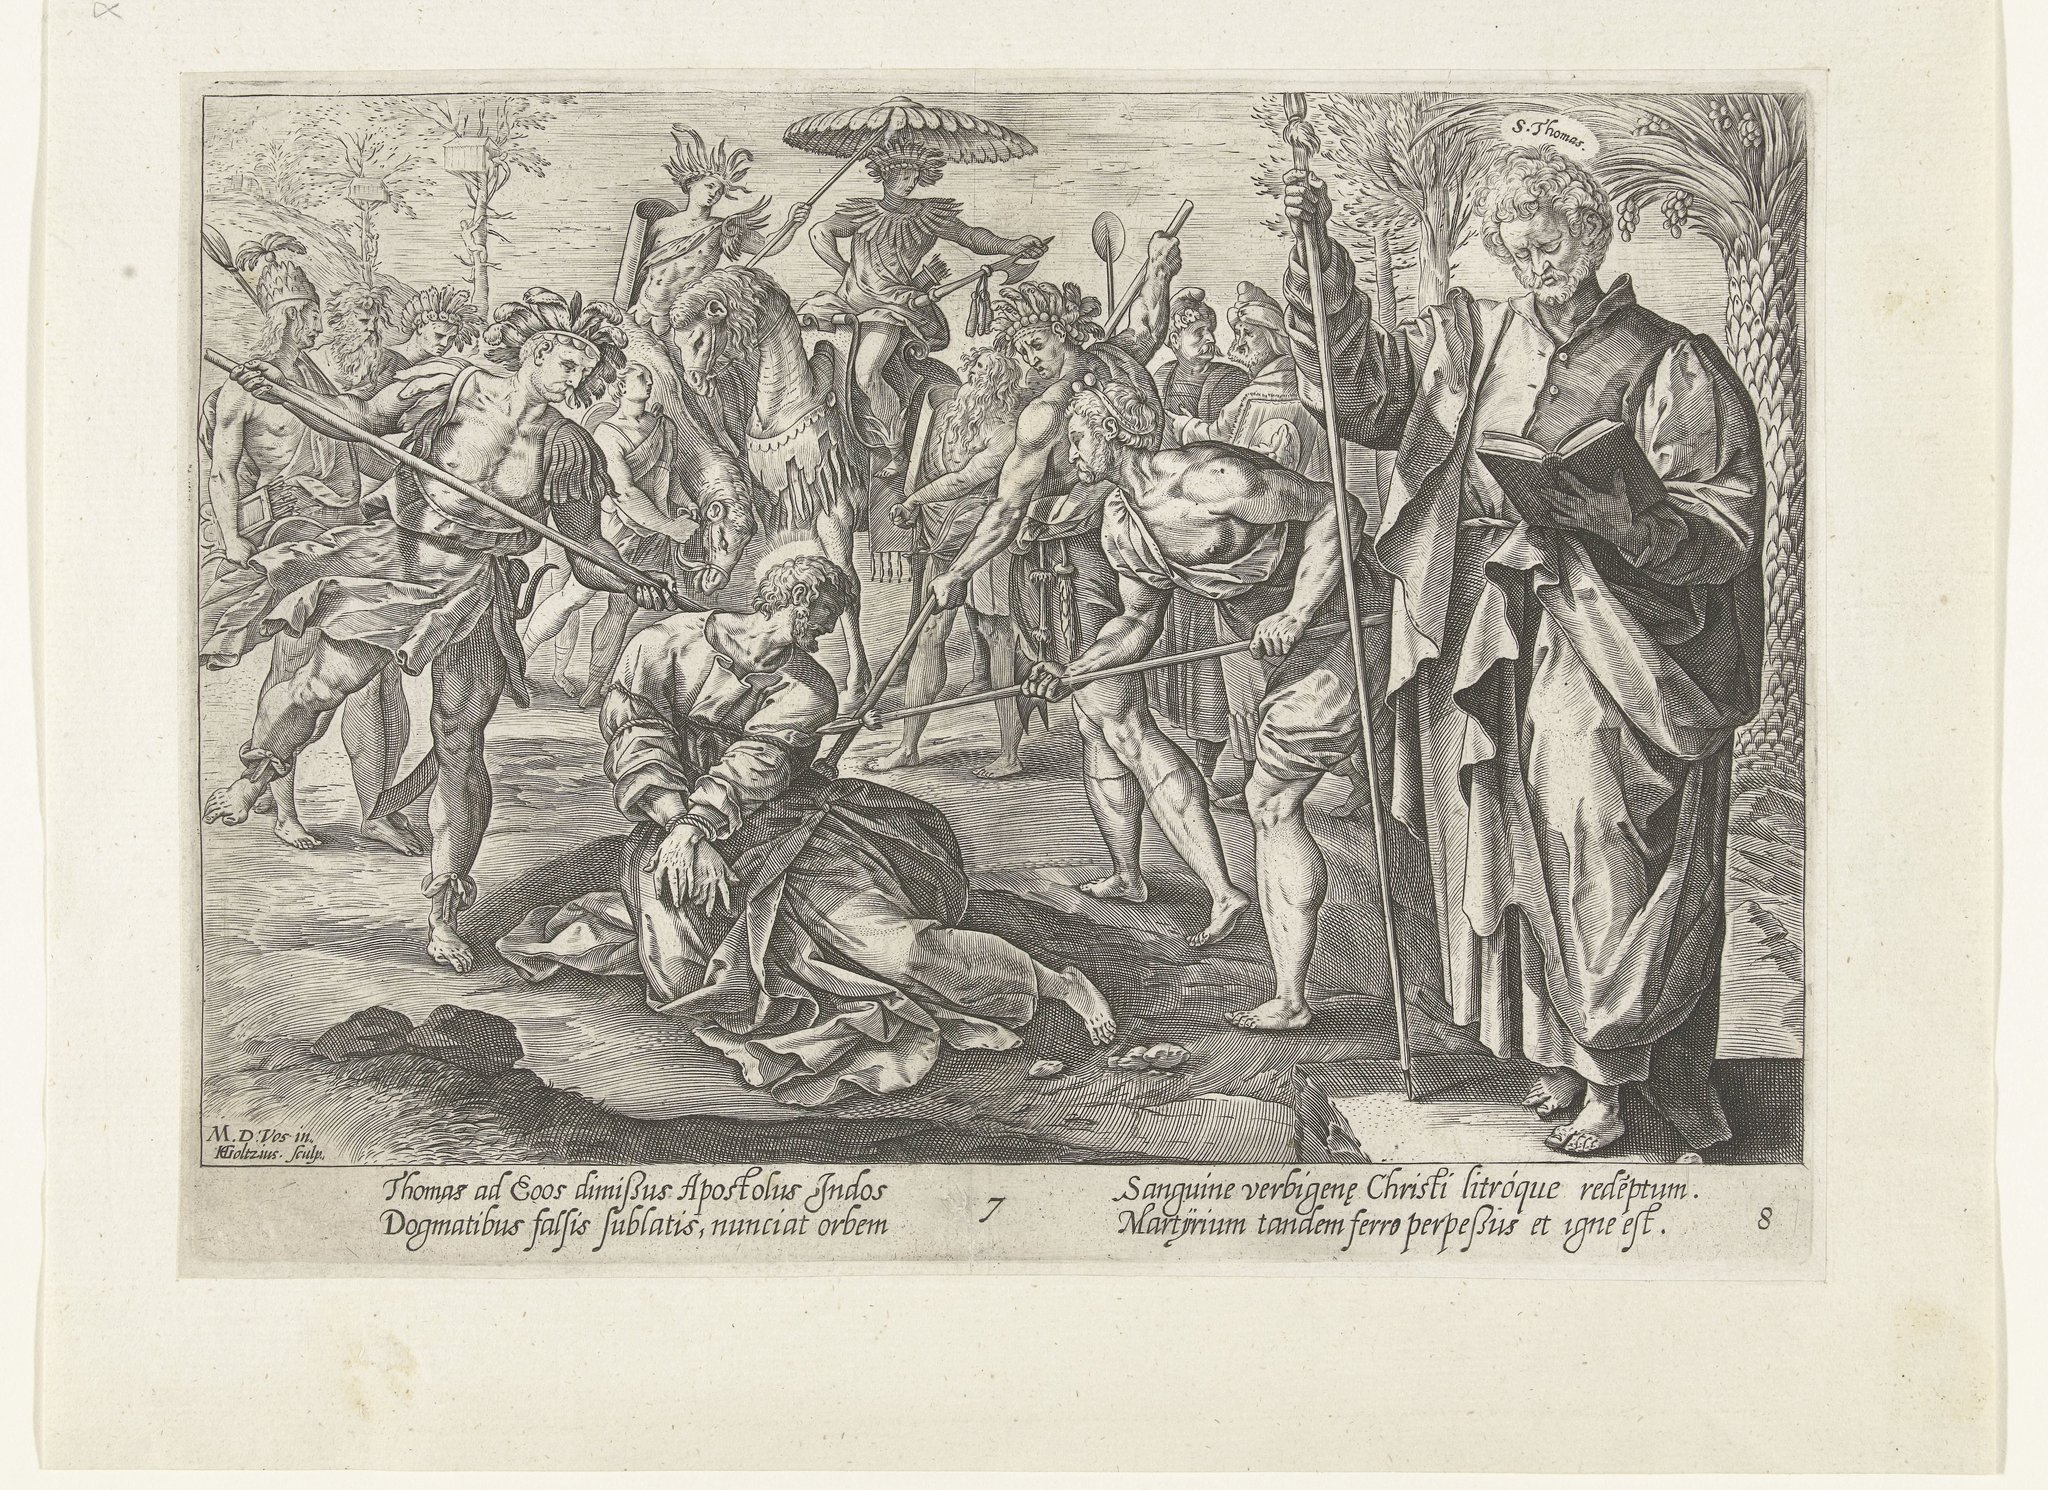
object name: print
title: Martelaarschap van Tomas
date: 1577-1582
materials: paper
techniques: engraving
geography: haarlem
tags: death of thomas: he is brought out of the city by four soldiers, who kill him with their lances, the apostle thomas; possible attributes: book, chalice, girdle, heart, lance or spear, scroll, square, stones - martyrdom, suffering, misfortune, death of male saint, native peoples of the americas, asiatic races and peoples: indians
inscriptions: collector's mark: Lugt 2228a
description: Apostel Tomas wordt met speren doodgestoken door Indiërs. Een deel van de afgebeelde Indiërs is voorgesteld als oorspronkelijke bewoners van Amerika, met verentooien en andere attributen. Rechts naast het tafereel van zijn marteldood staat hij nogmaals afgebeeld, lezend in een boek, een speer in de hand. Onder de voorstelling tweemaal twee regels Latijn. Deze prent is onderdeel van een serie van twaalf (of dertien?) prenten van (Christus en?) de apostelen, meer specifiek van de martelingen die ze hebben ondergaan.